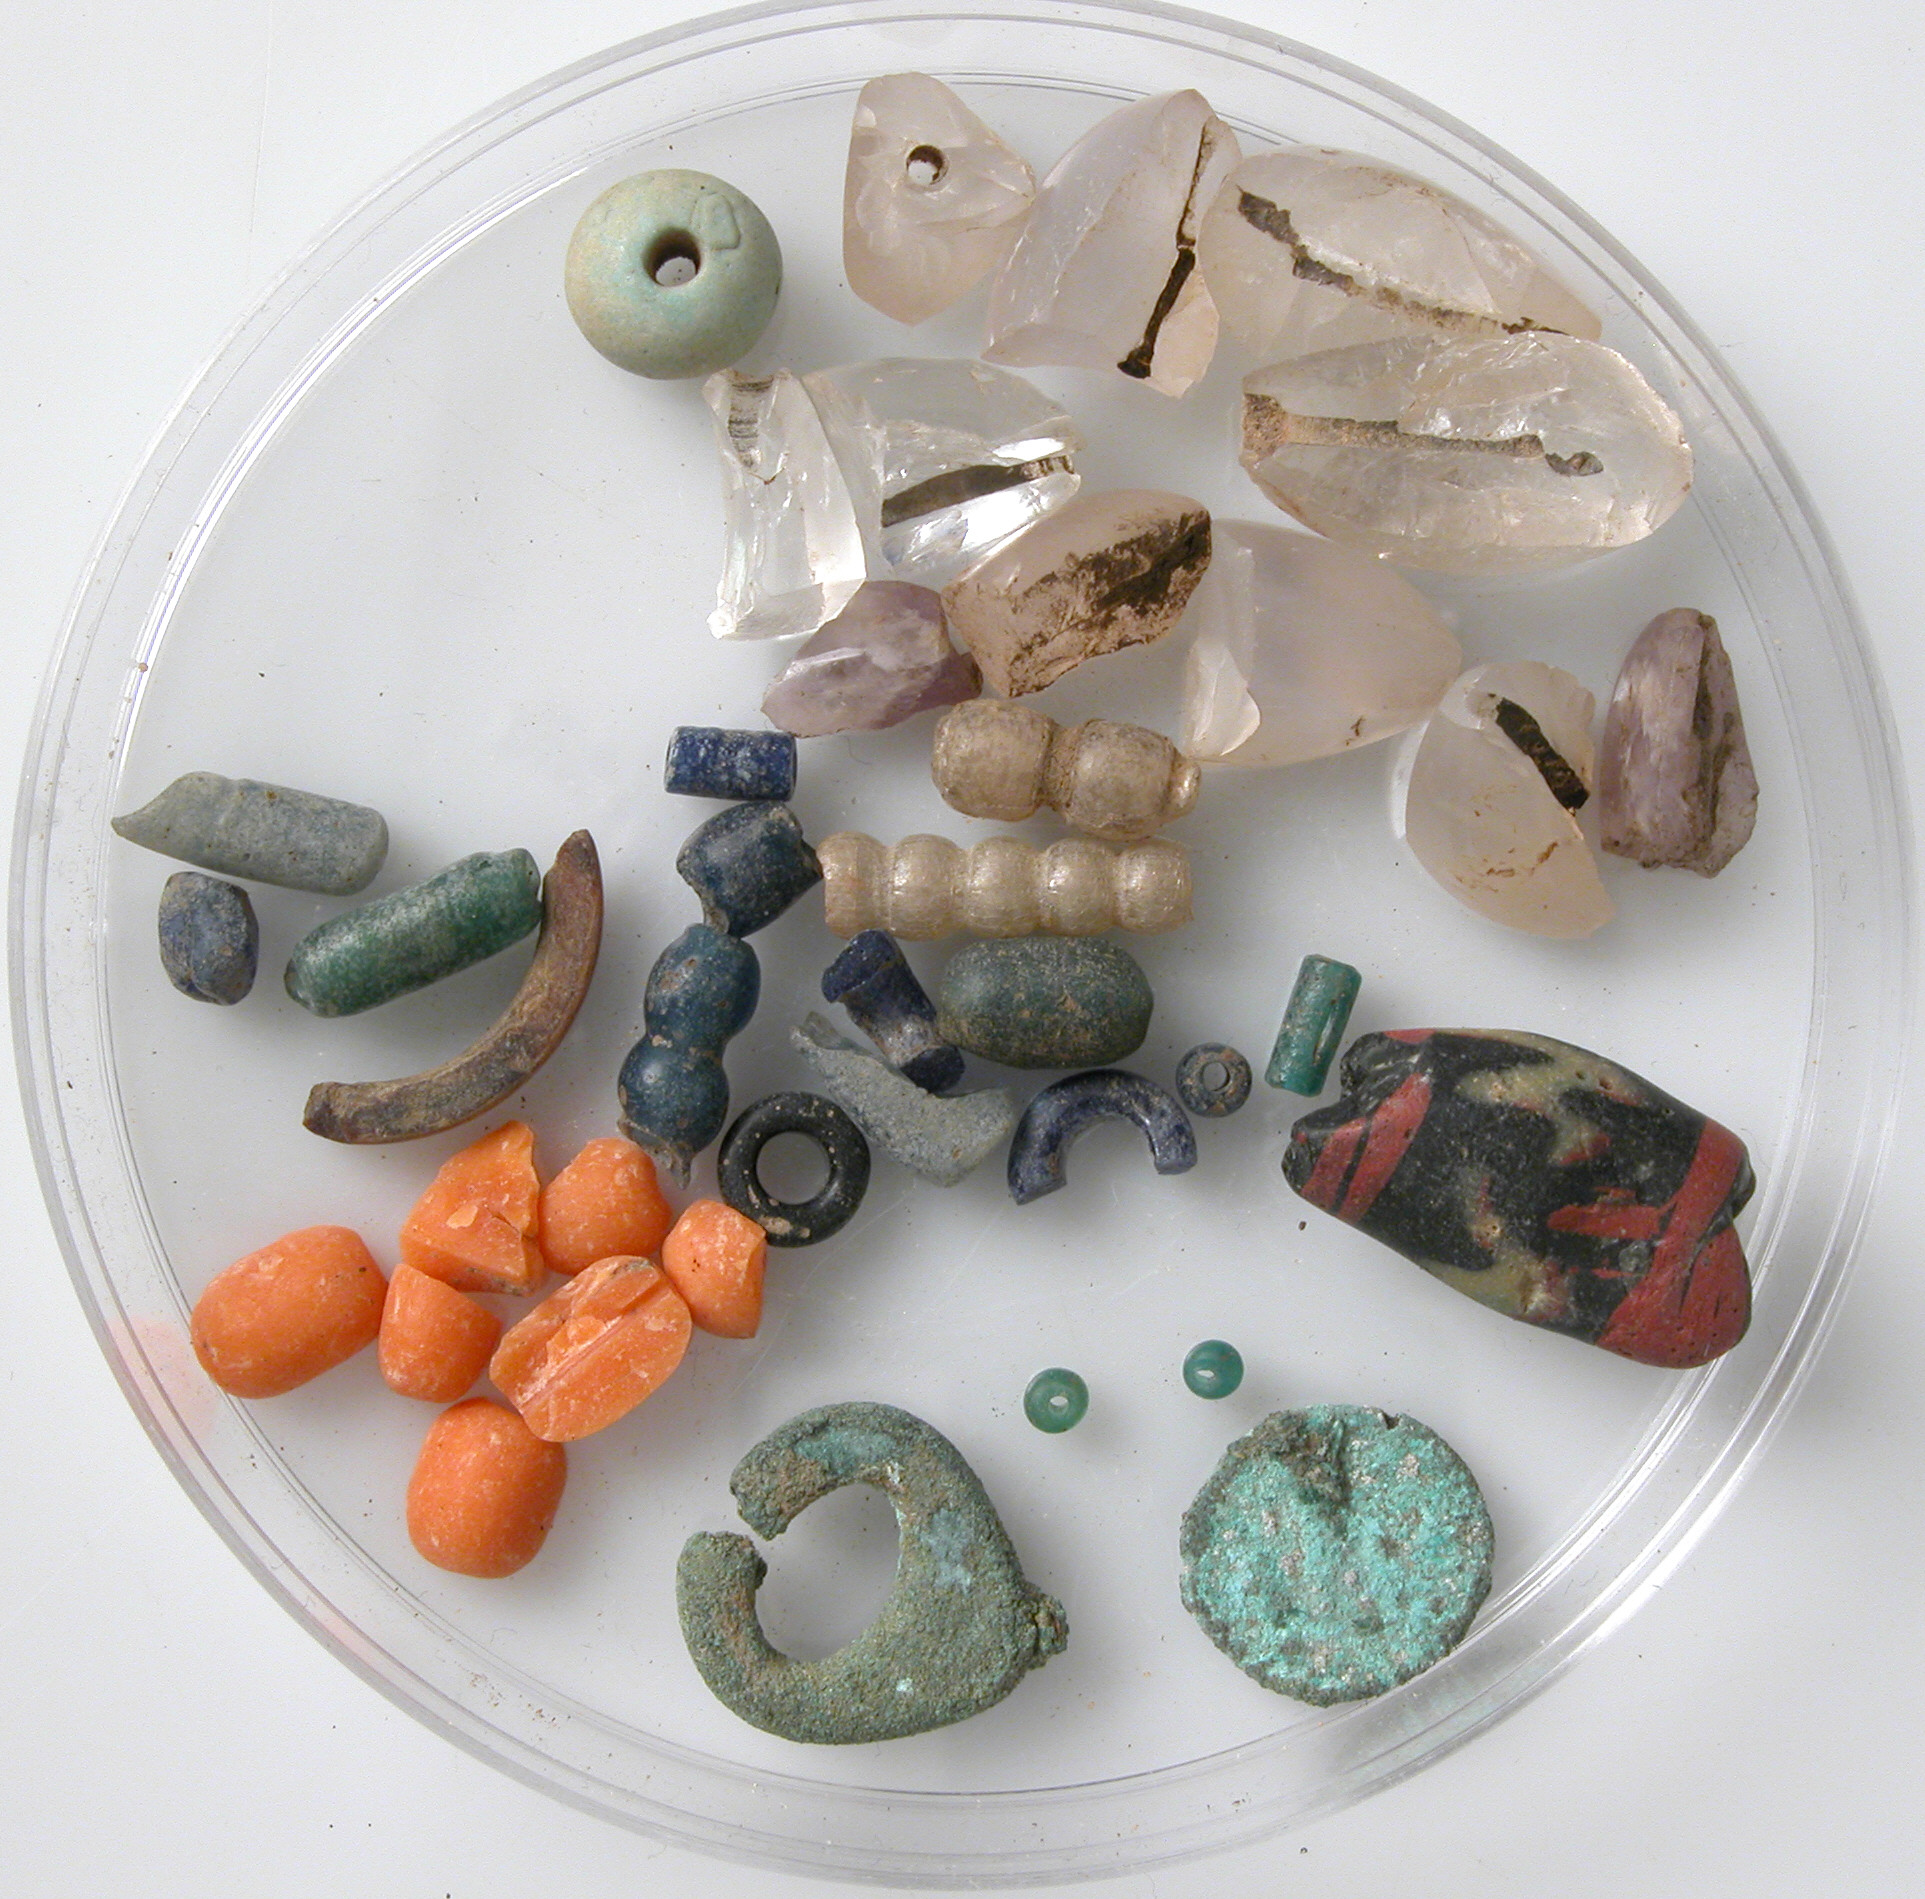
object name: fragment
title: Coin and Bead Fragments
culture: coptic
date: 301-700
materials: copper alloy, coral, glass, quartz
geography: egypt